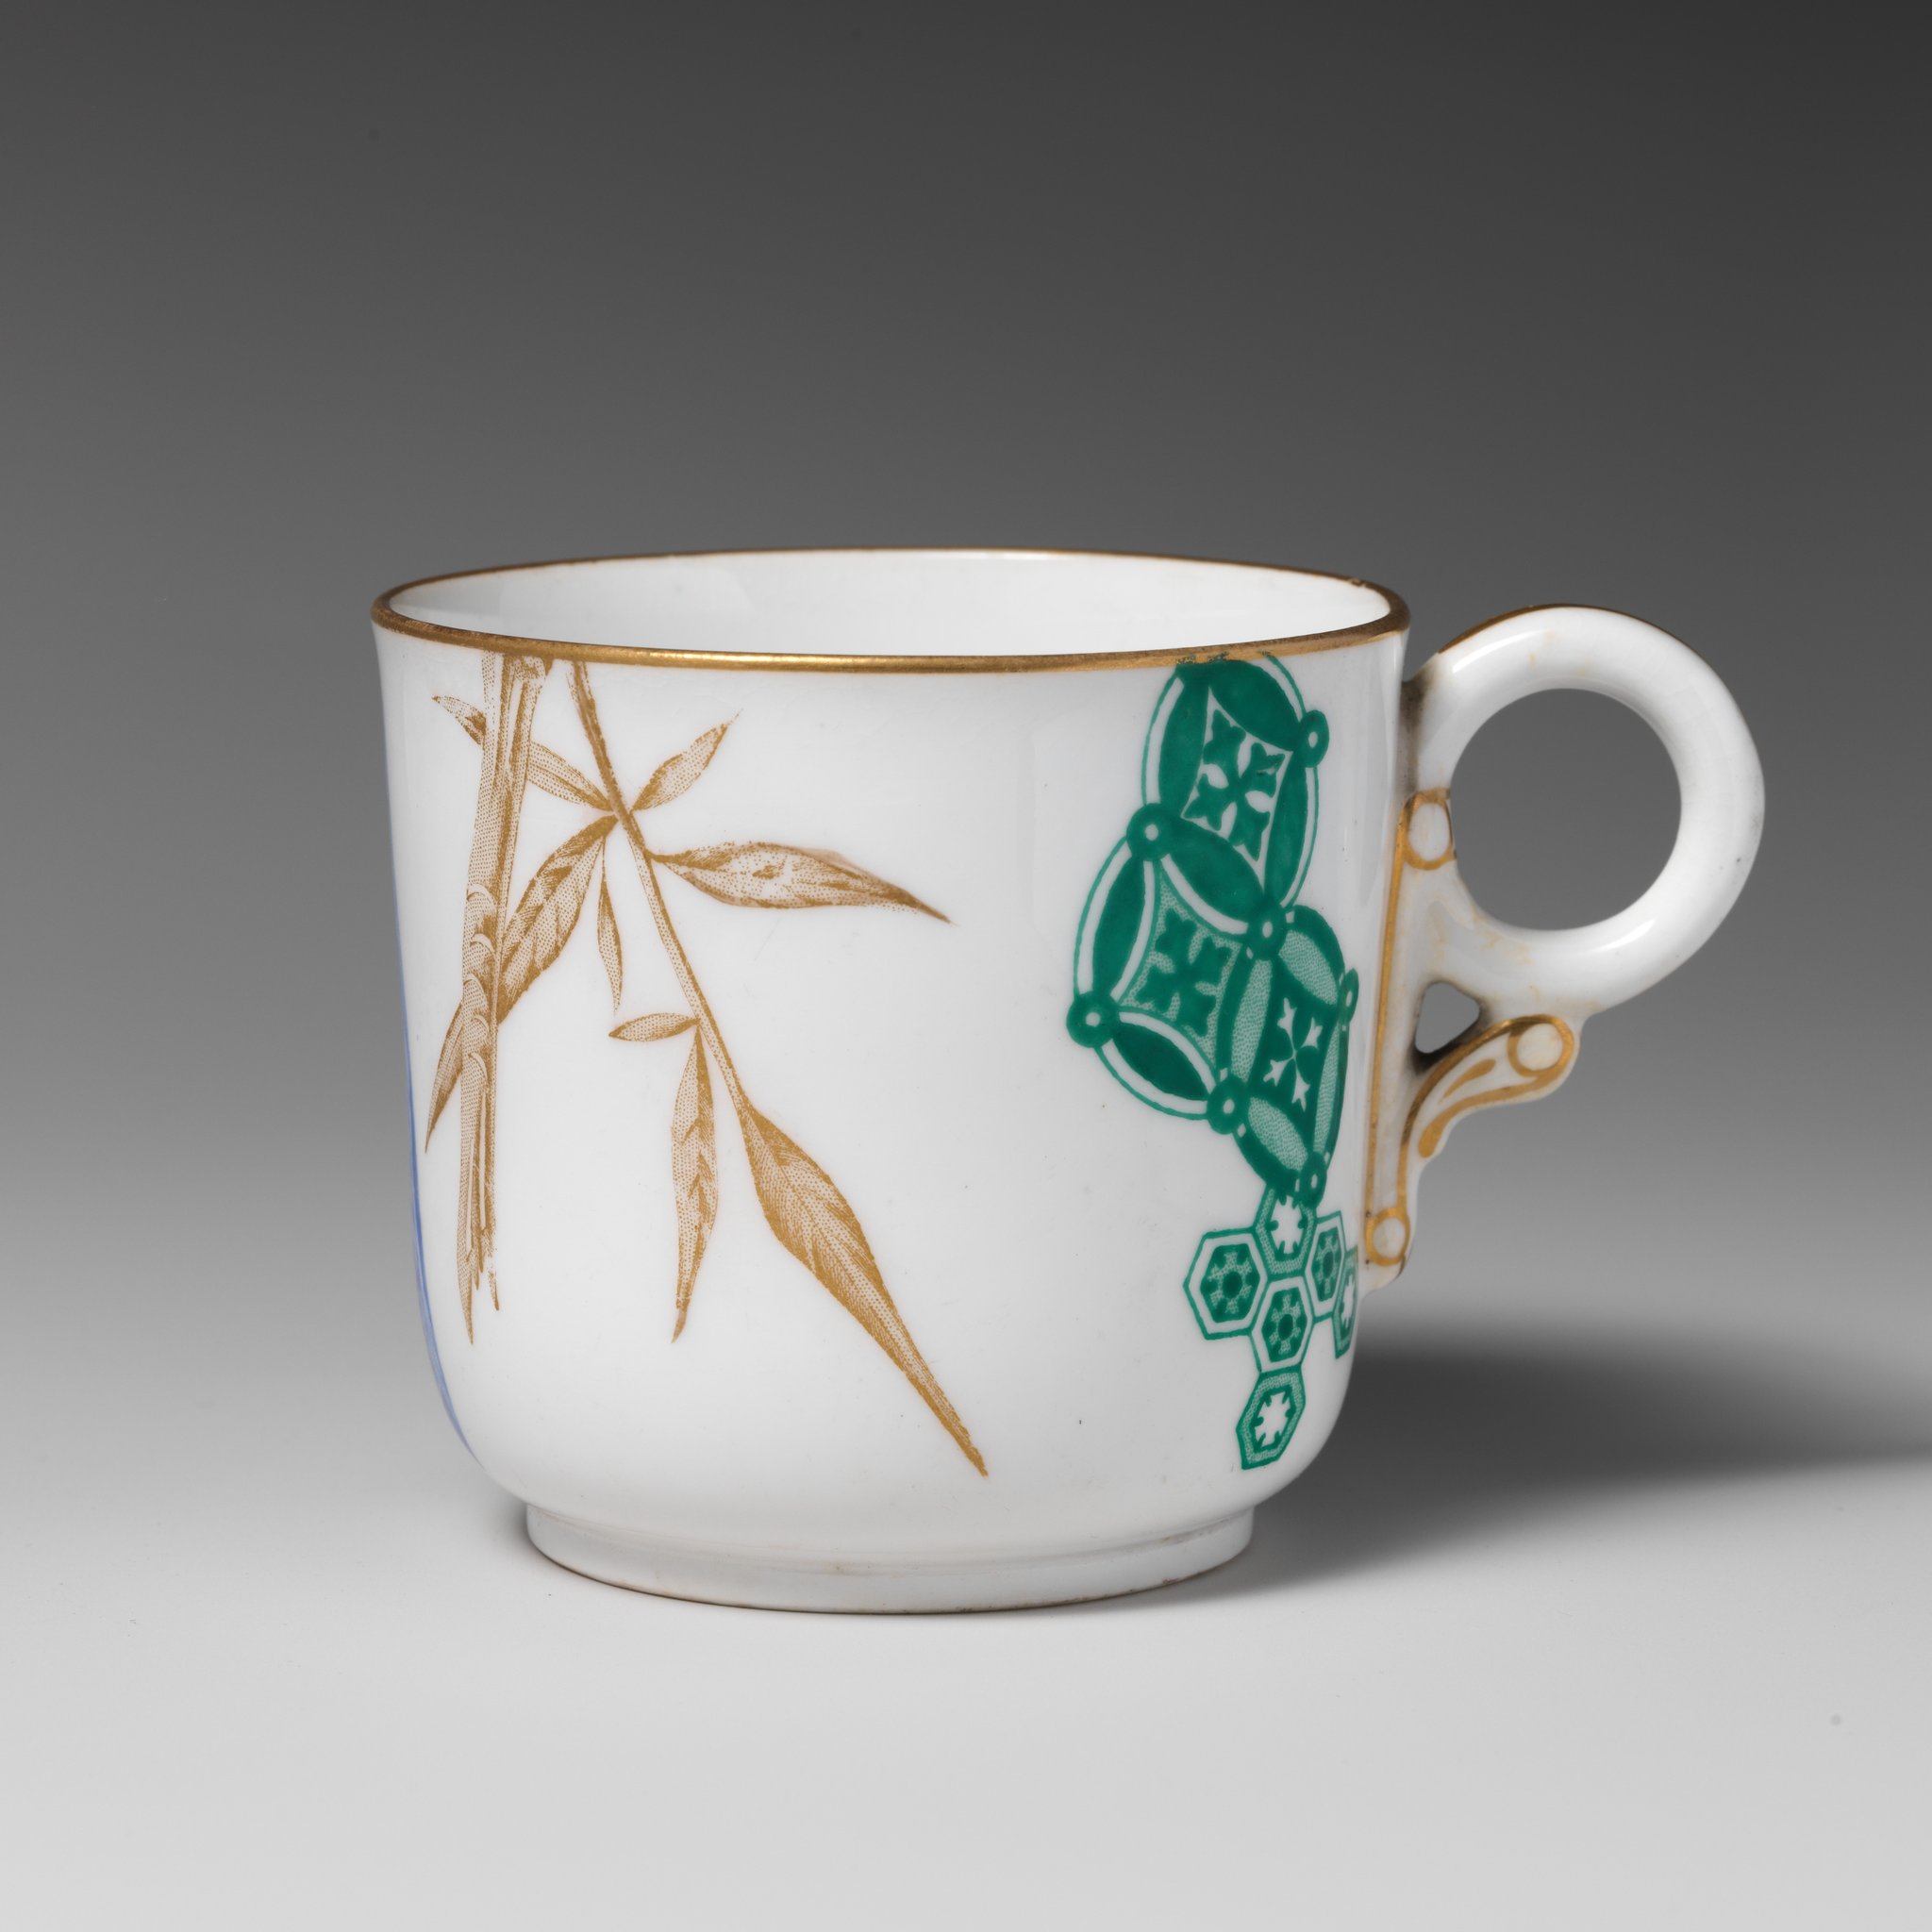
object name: teacup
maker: worcester factory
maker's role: maker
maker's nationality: british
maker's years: 1751-2008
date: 1876-1877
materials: porcelain